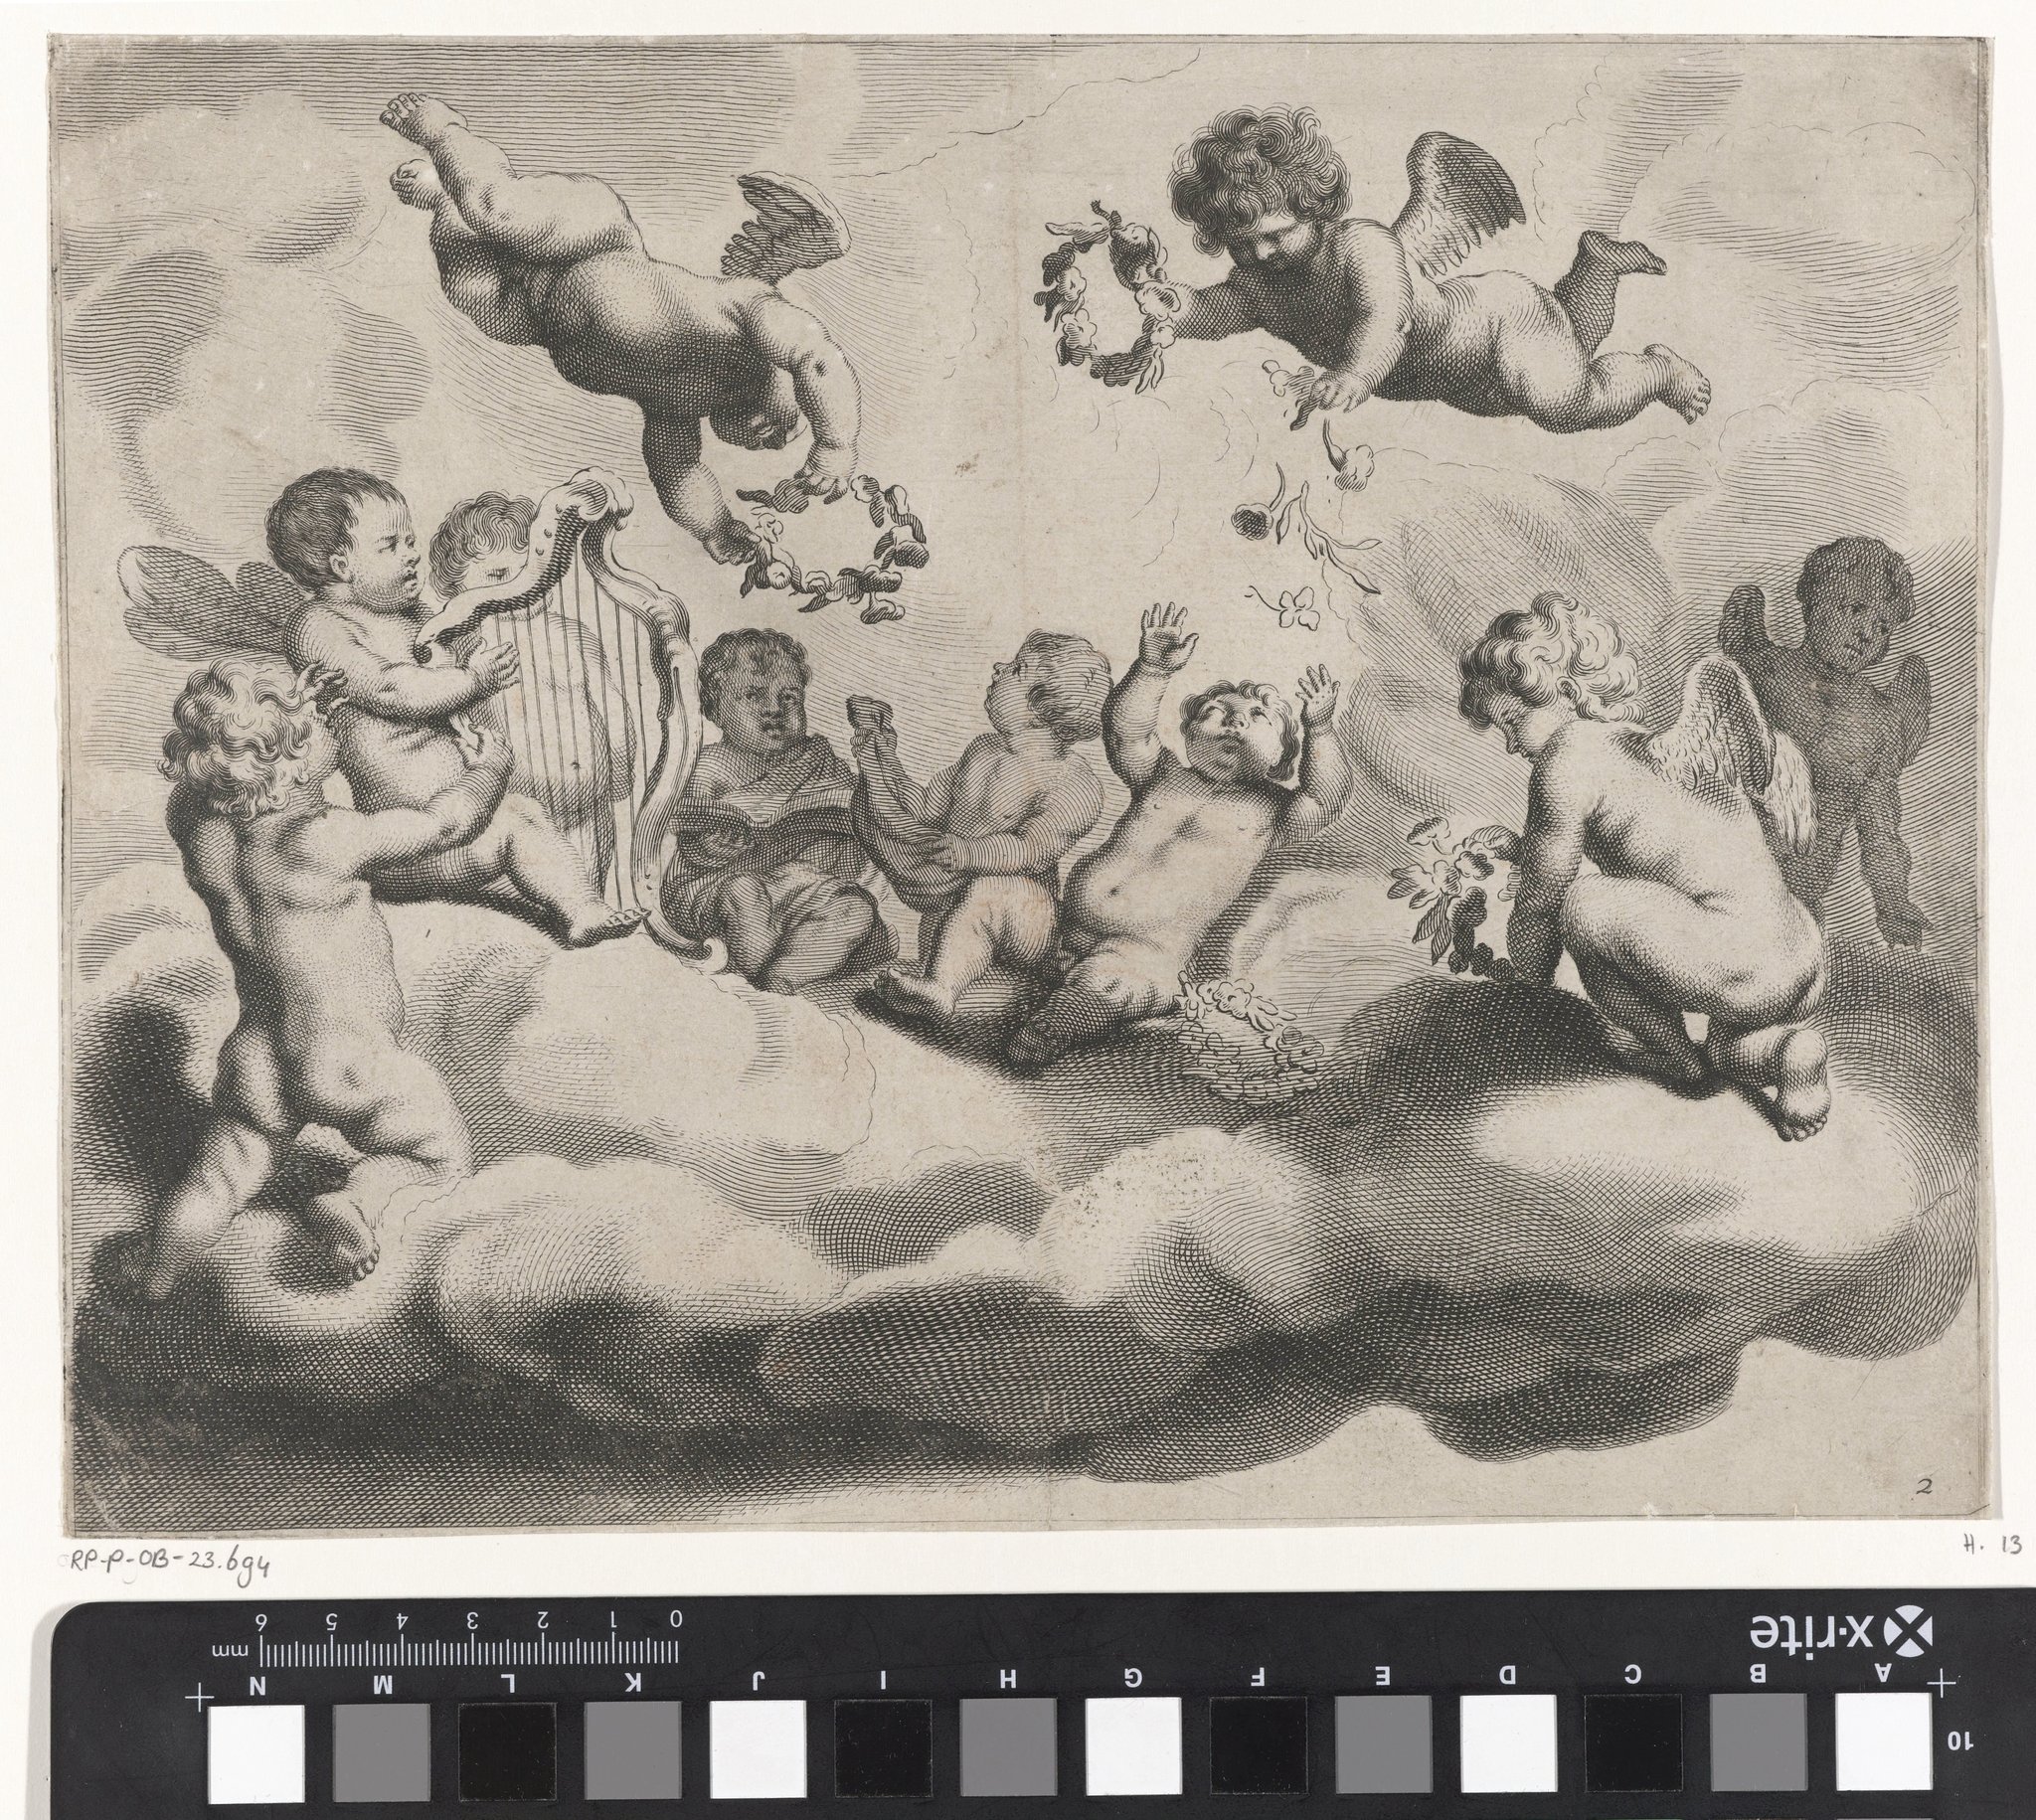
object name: print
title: Putti op een wolk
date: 1640-1655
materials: paper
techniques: engraving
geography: amsterdam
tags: flowers, clouds, harp, cupids: 'amores', 'amoretti', 'putti'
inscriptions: collector's mark: Lugt 240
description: Een groep putti op een wolk. Links bespeelt een putto de harp, een ander zingt daarbij uit een boek. Twee vliegende putti strooien bloemen.